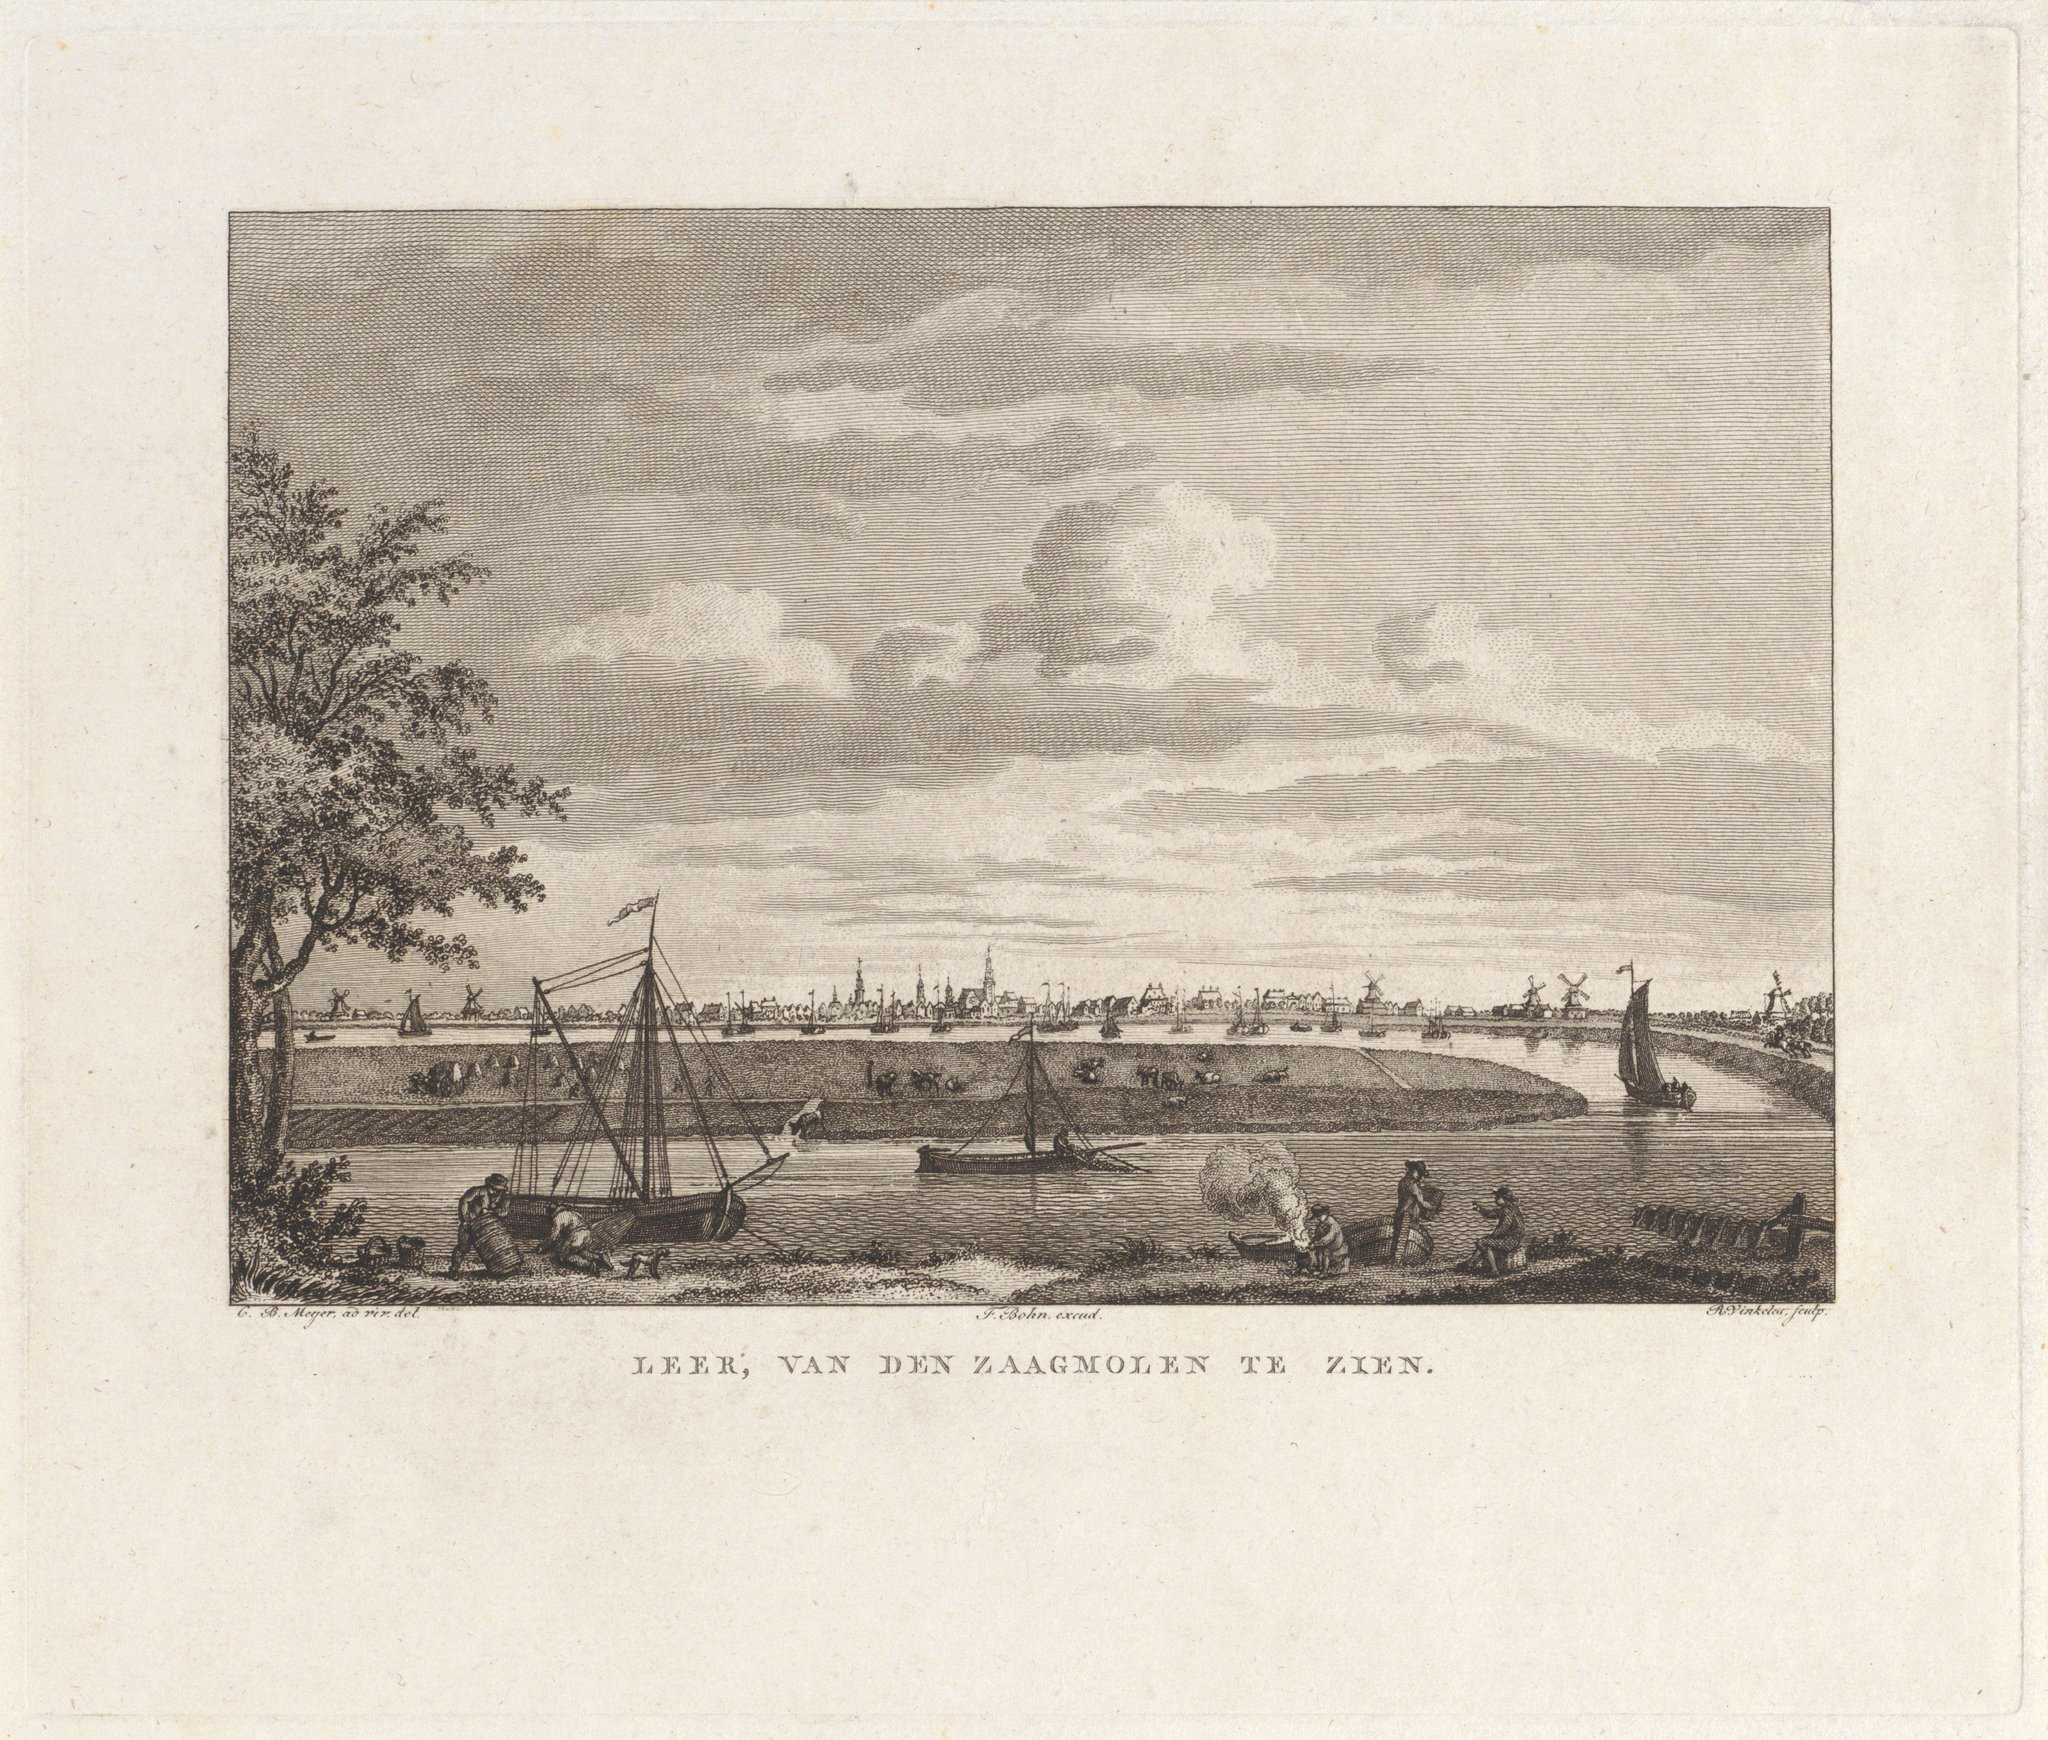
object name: print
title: Gezicht op Leer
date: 1751-1816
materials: paper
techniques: engraving, etching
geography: amsterdam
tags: sailing-ship, sailing-boat, river, prospect of city, town panorama, silhouette of city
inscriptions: collector's mark: Lugt 2228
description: Silhouet van de stad Leer. Op de voorgrond bedrijvigheid aan een rivier.